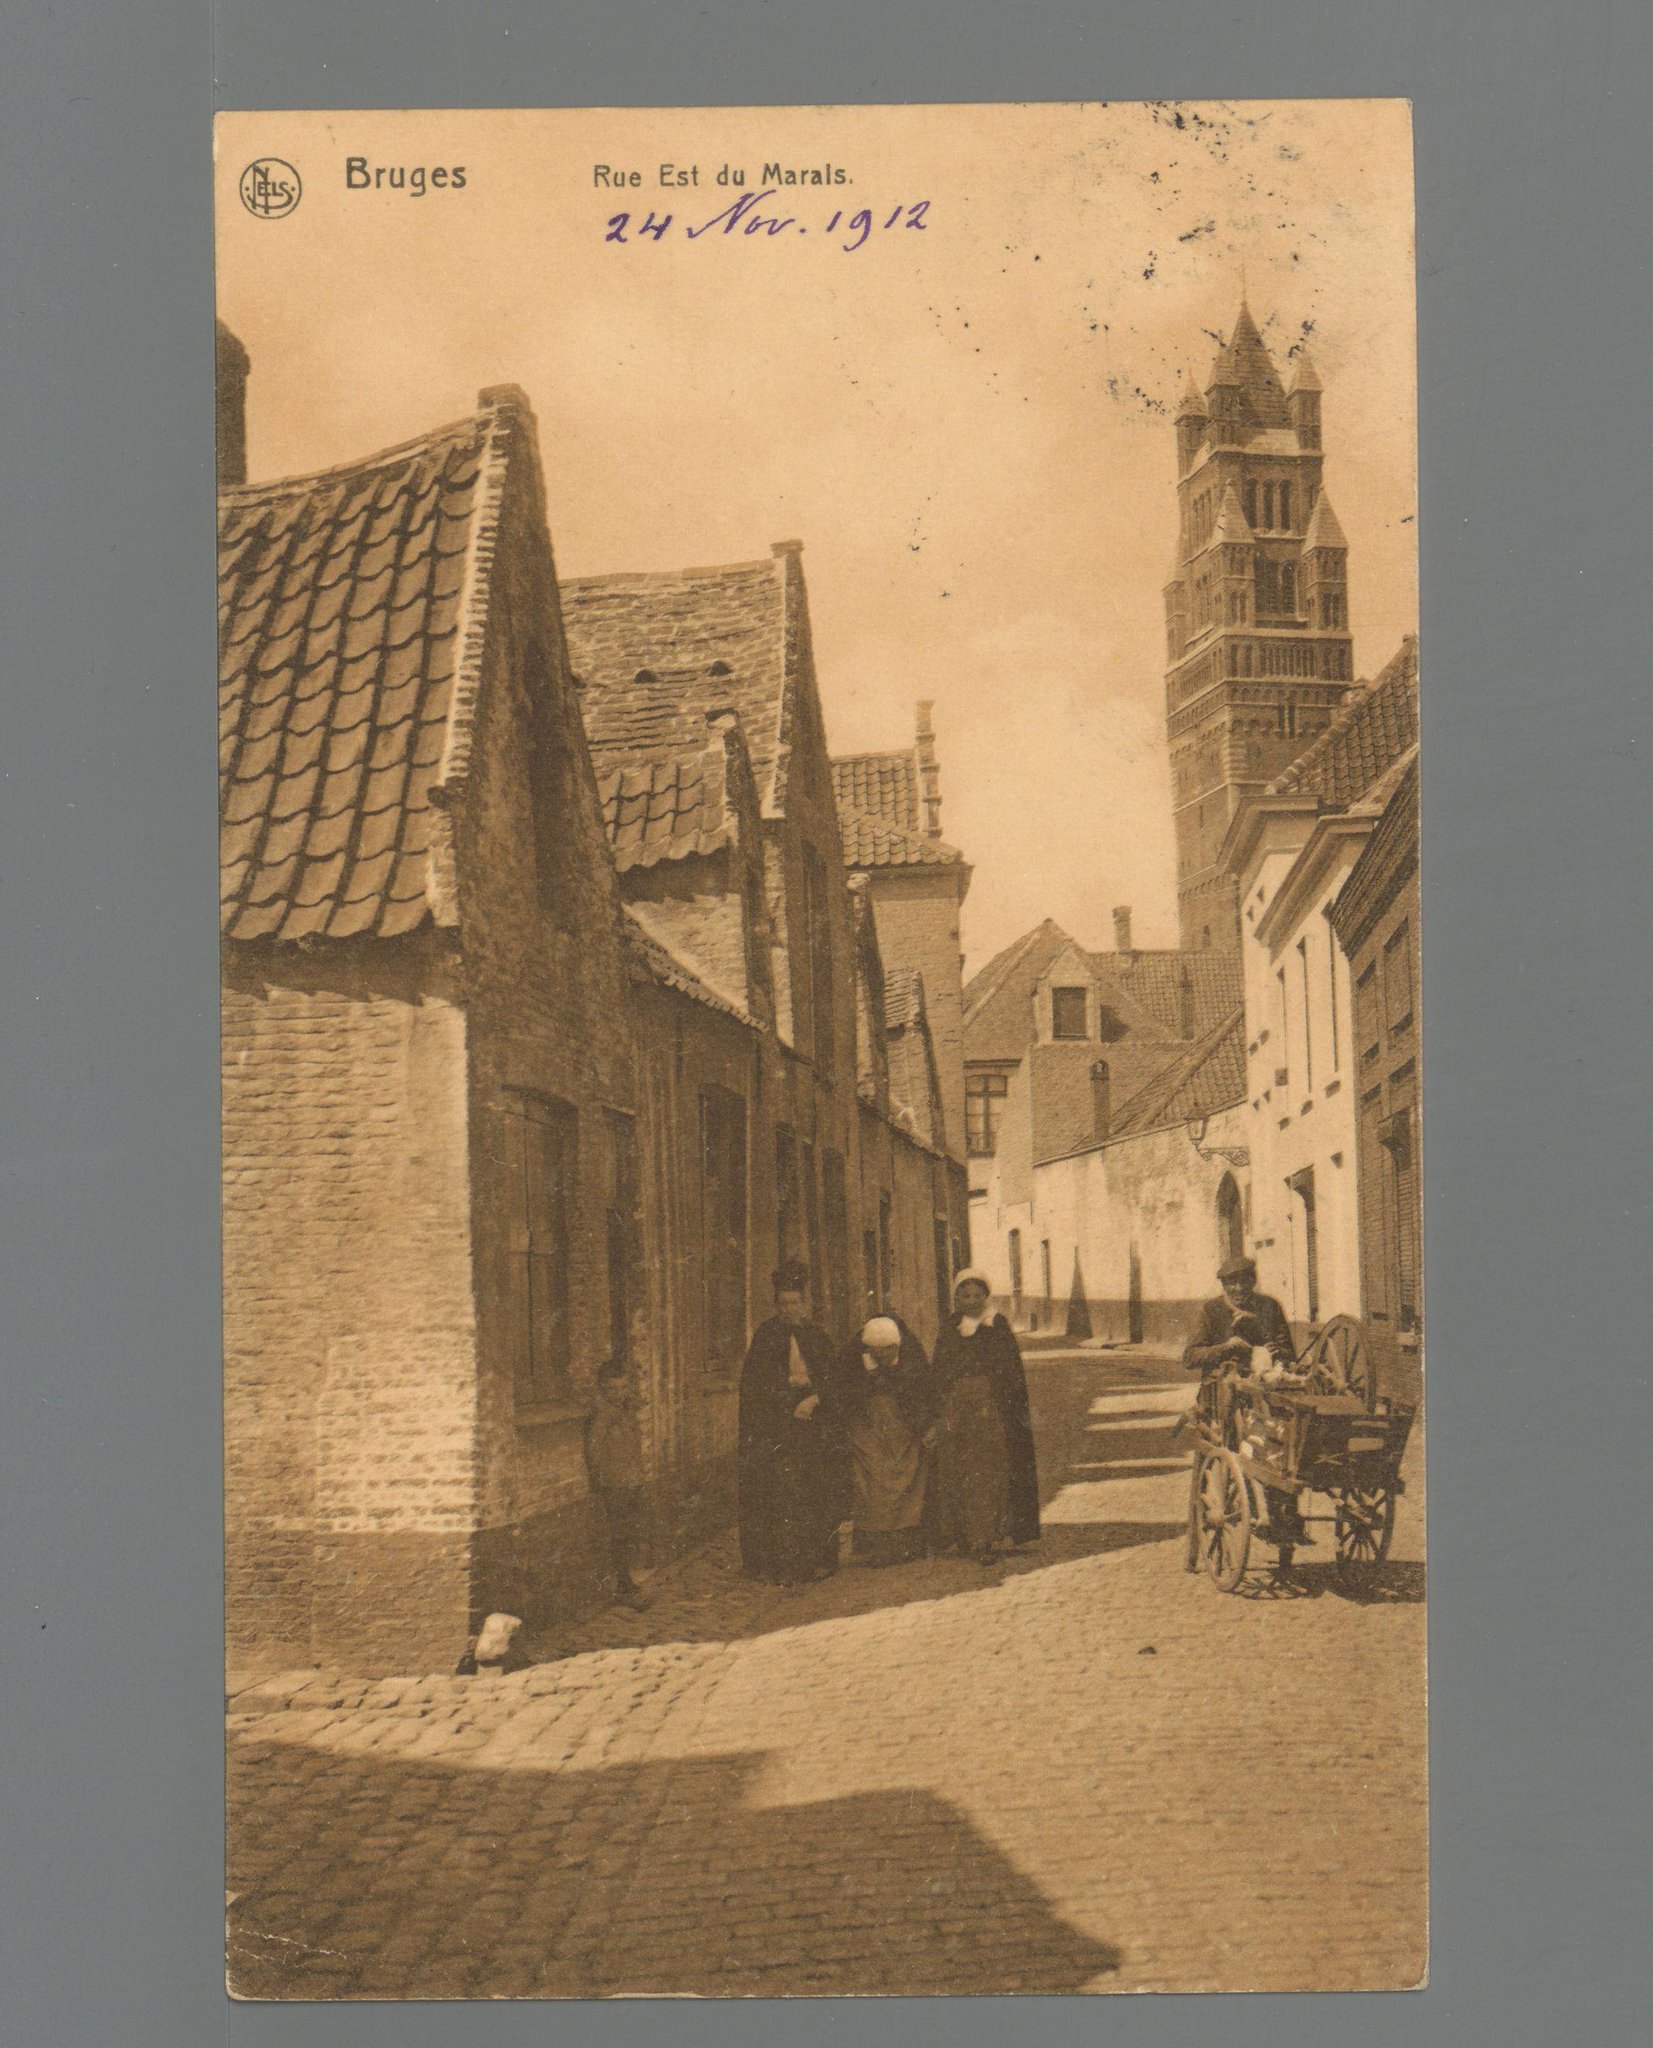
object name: ansichtkaart, prentbriefkaart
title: Bruges. Rue Est du Marais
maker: Anonymous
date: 1907-1912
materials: cardboard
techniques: photograph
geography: brussels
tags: church (exterior), street (+ city(-scape) with figures, staffage), bruges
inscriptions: postage stamp